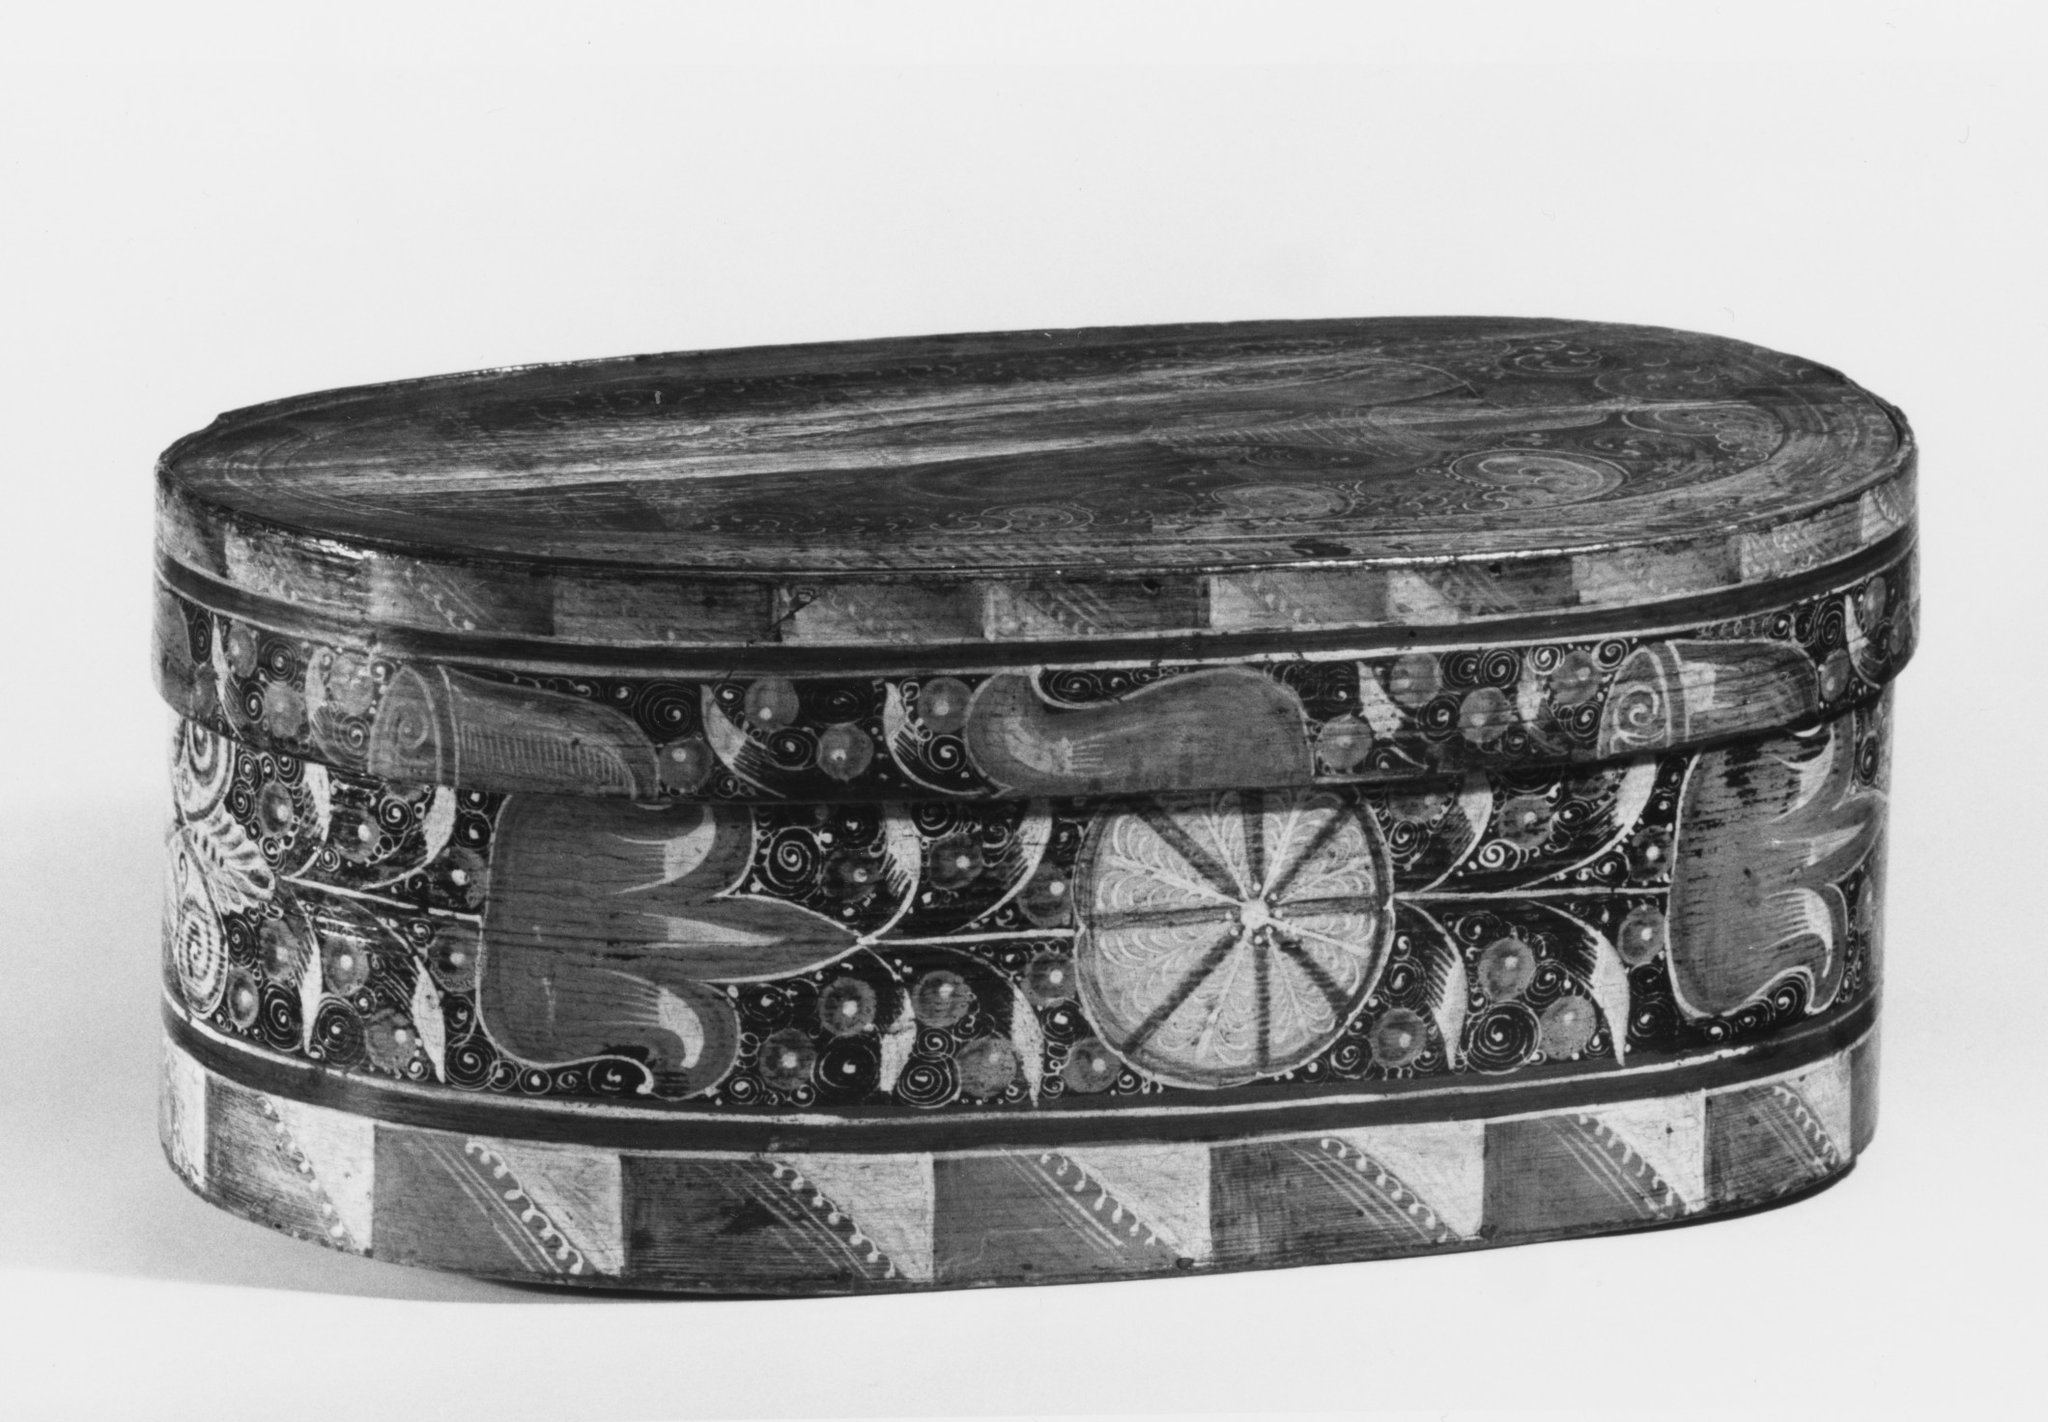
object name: bride box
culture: american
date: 1820-1825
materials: wood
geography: united states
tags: flowers